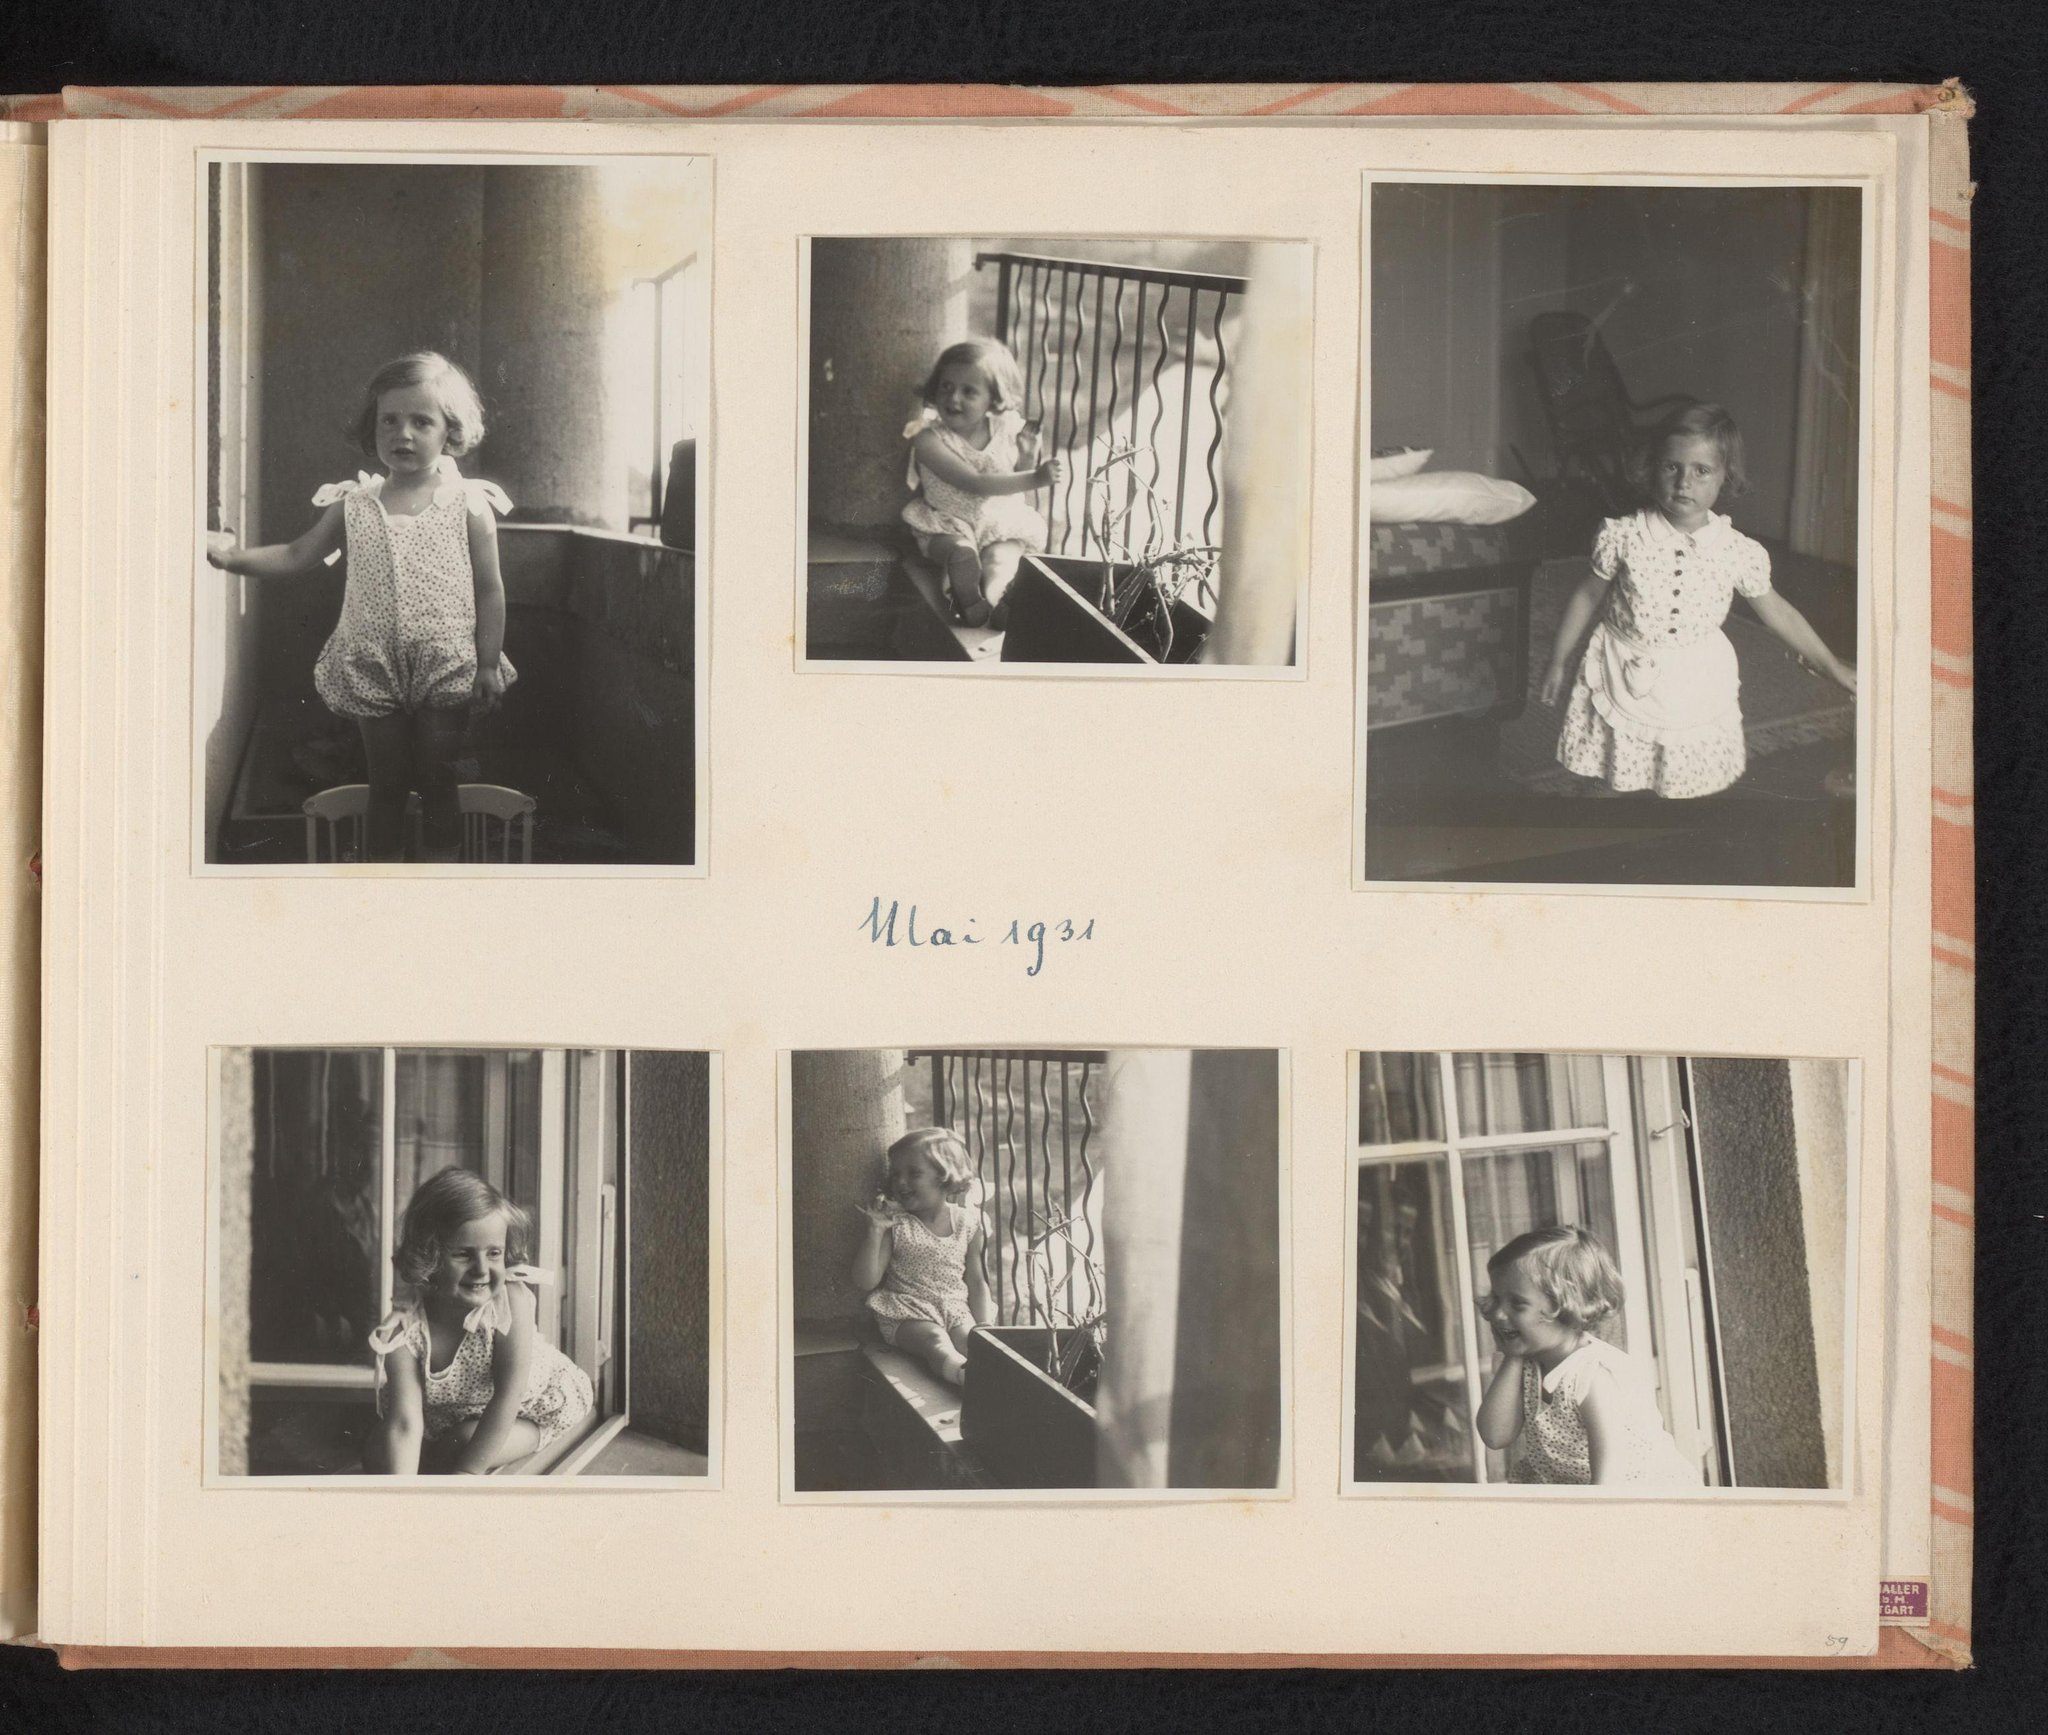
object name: album leaf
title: Isabel Wachenheimer om en rond het balkon van de woning van de familie Wachenheimer, mei 1931, München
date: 1905-1931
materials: paper, photographic support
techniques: gelatin silver print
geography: munich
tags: leiden, isabel wachenheimer-elon, family life at home, infant, baby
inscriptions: inscription: ‘Mai 1931’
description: Albumblad met zes foto's. Alle foto's, Isabel Wachenheimer. Onderdeel van het fotoalbum met foto's van Isabel Wachenheimer als kind (1928-1931).